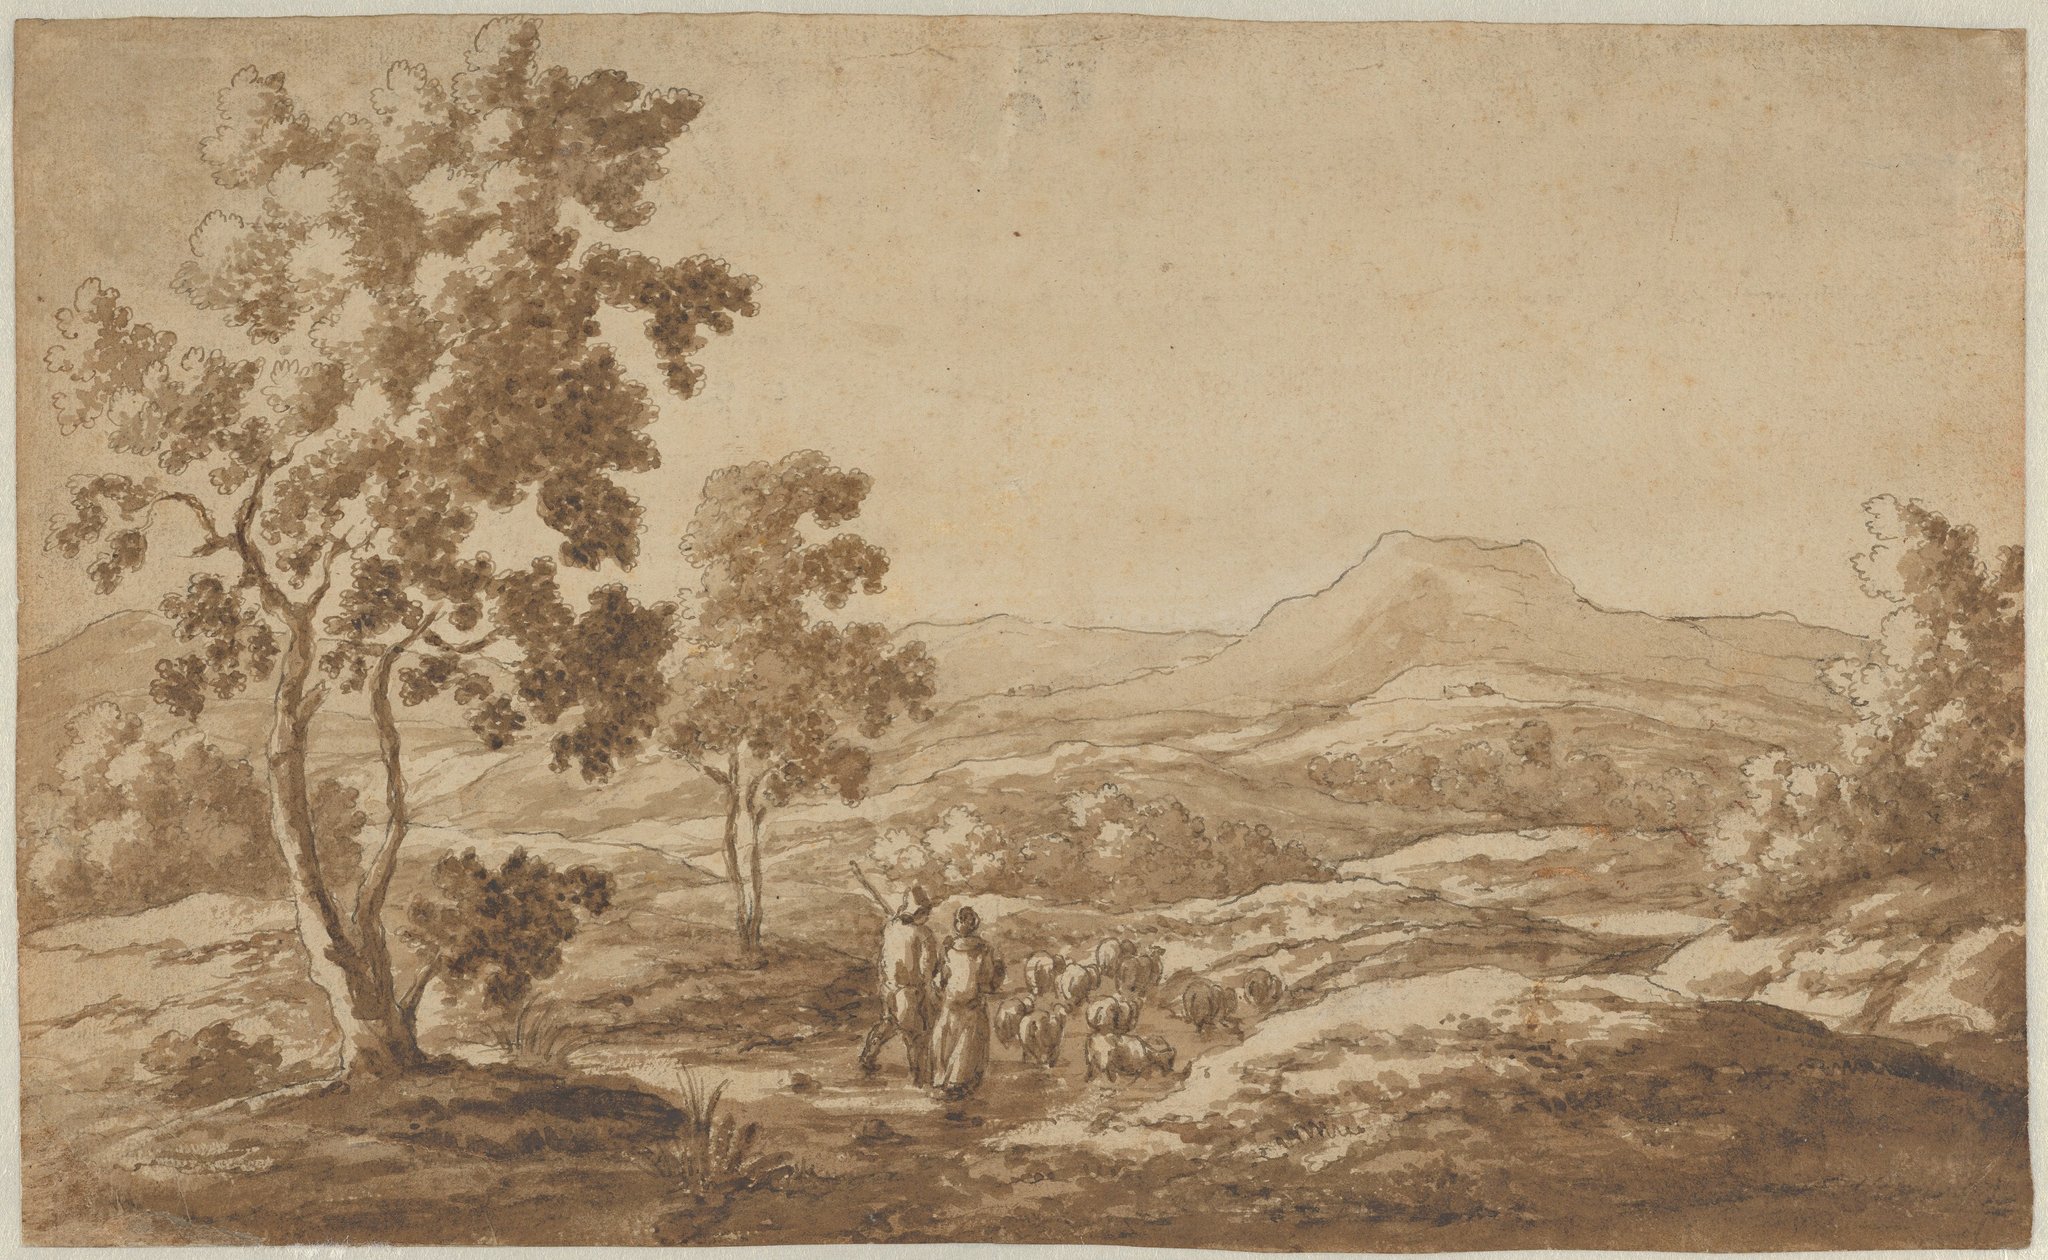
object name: drawing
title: Southern Landscape with Shepherds and Sheep; verso: Study of a Sheep's Head (?)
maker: simon van der does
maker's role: artist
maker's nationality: dutch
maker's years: 1653-1717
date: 1676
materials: ink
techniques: brush, pen, wash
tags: men,sheep,landscapes,trees,shepherds